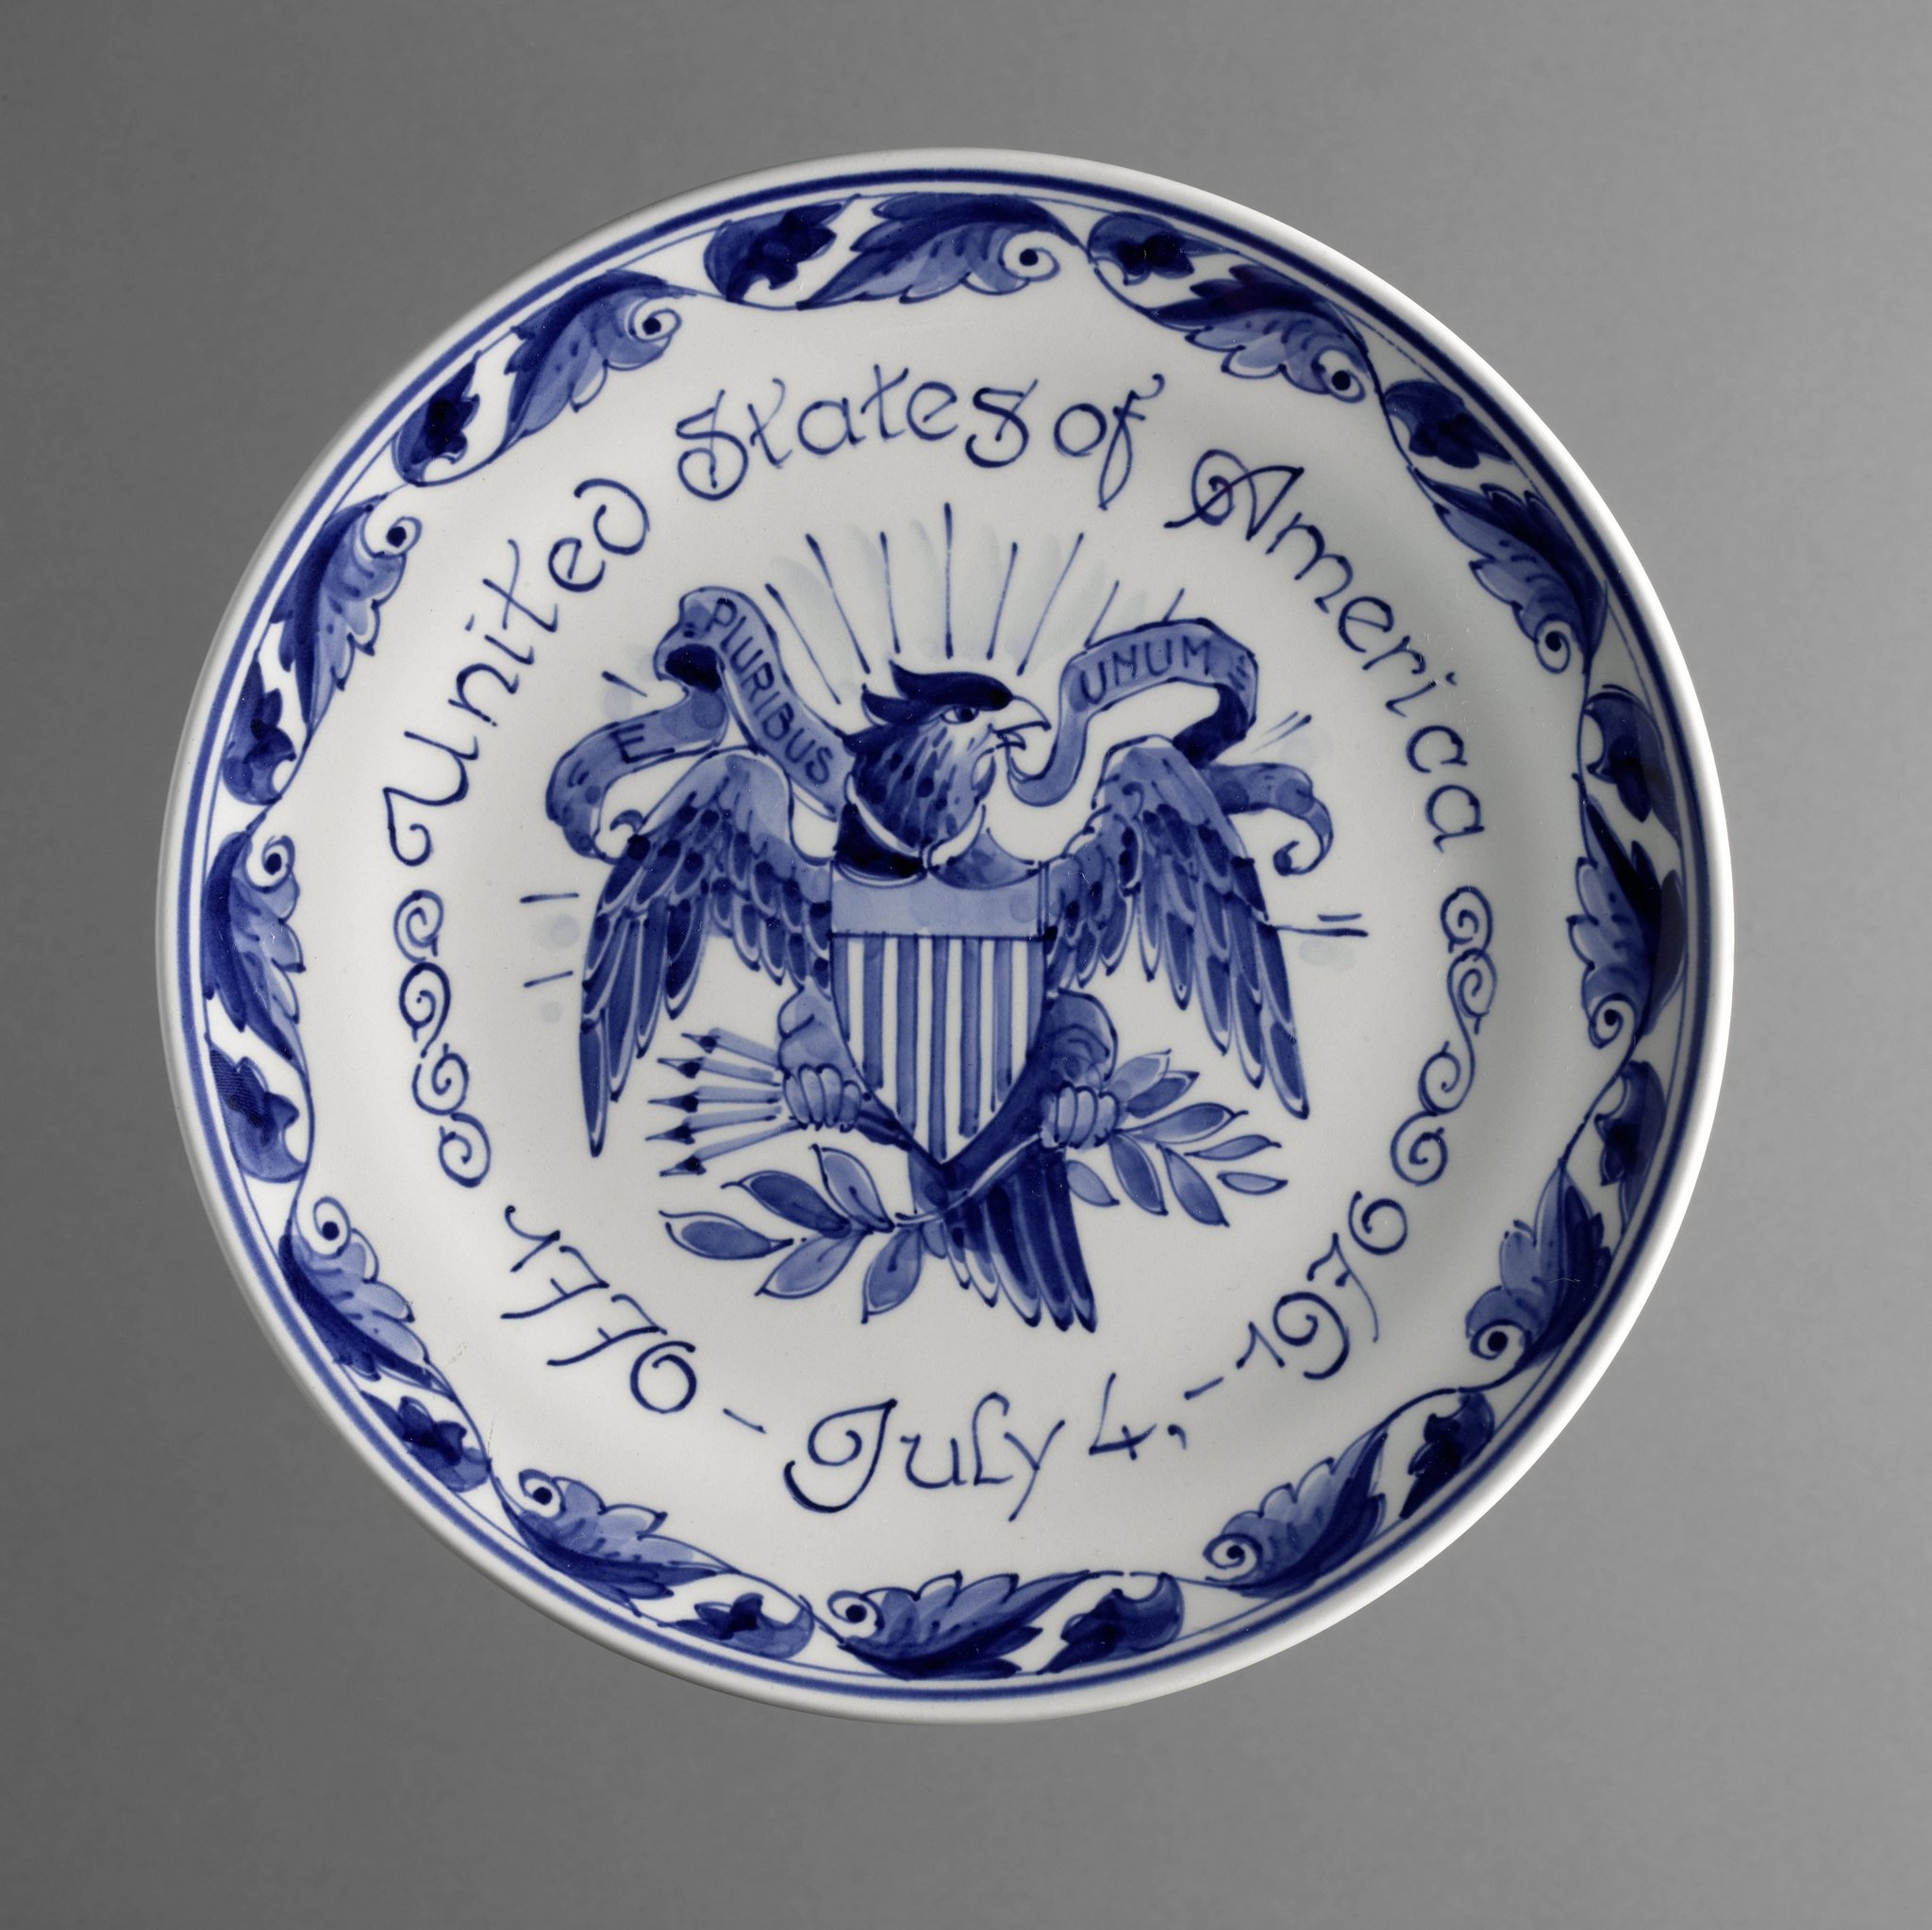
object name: herinneringsbord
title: United States of America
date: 1976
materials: earthenware, glaze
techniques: painted, vitrification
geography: delft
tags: united states of america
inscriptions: check stamp: ‘ßO’, factory mark: ‘JT Delft’, title: ‘United States of America’, edition: ‘82/5000’, title: ‘E PLURIBUS UNUM’, label: ‘FOCKE & MELTZER’, date: ‘1776 - july 4 - 1976’, mark: ‘TQ09. CV.’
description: Bord, blauw geschilderd met afbeelding van een arend met vijf pijlen en een wapenbord om de nek. In zijn snavel een lint met opschrift. Achterzijde twee blauwe randen en v.z.v. twee gaatjes en ijzerdraad om bord op te hangen. Gemerkt en v.z.v. bruin etiket.